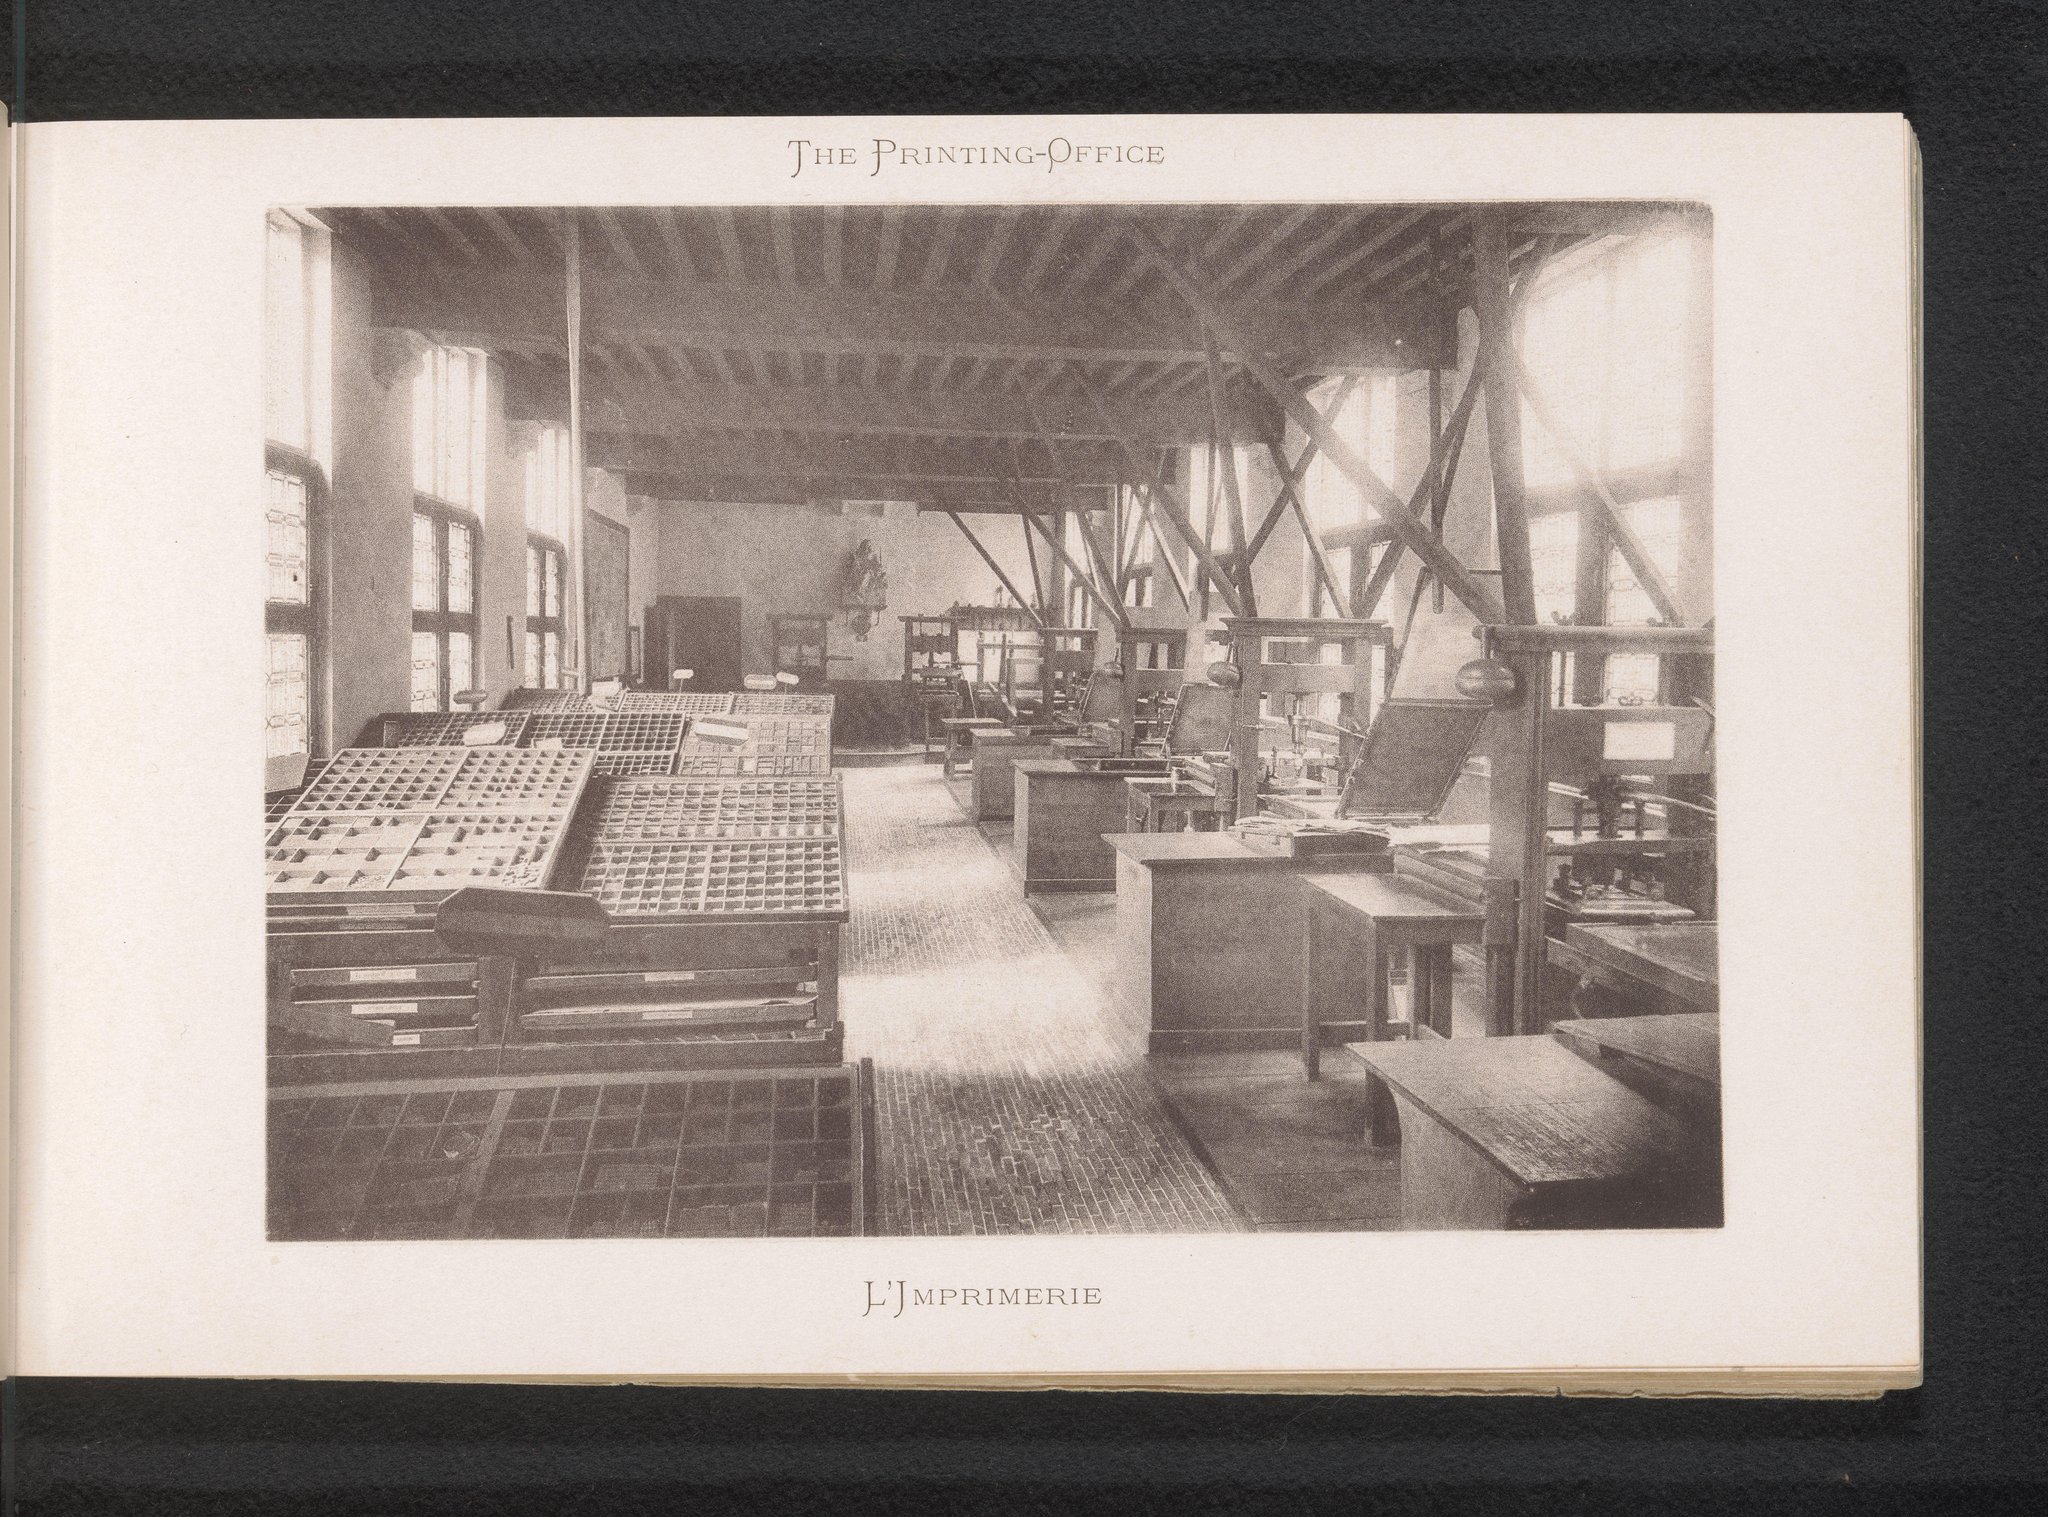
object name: page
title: L'imprimerie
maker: Anonymous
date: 1892-1897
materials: paper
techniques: photograph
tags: printing press, printing, printing office